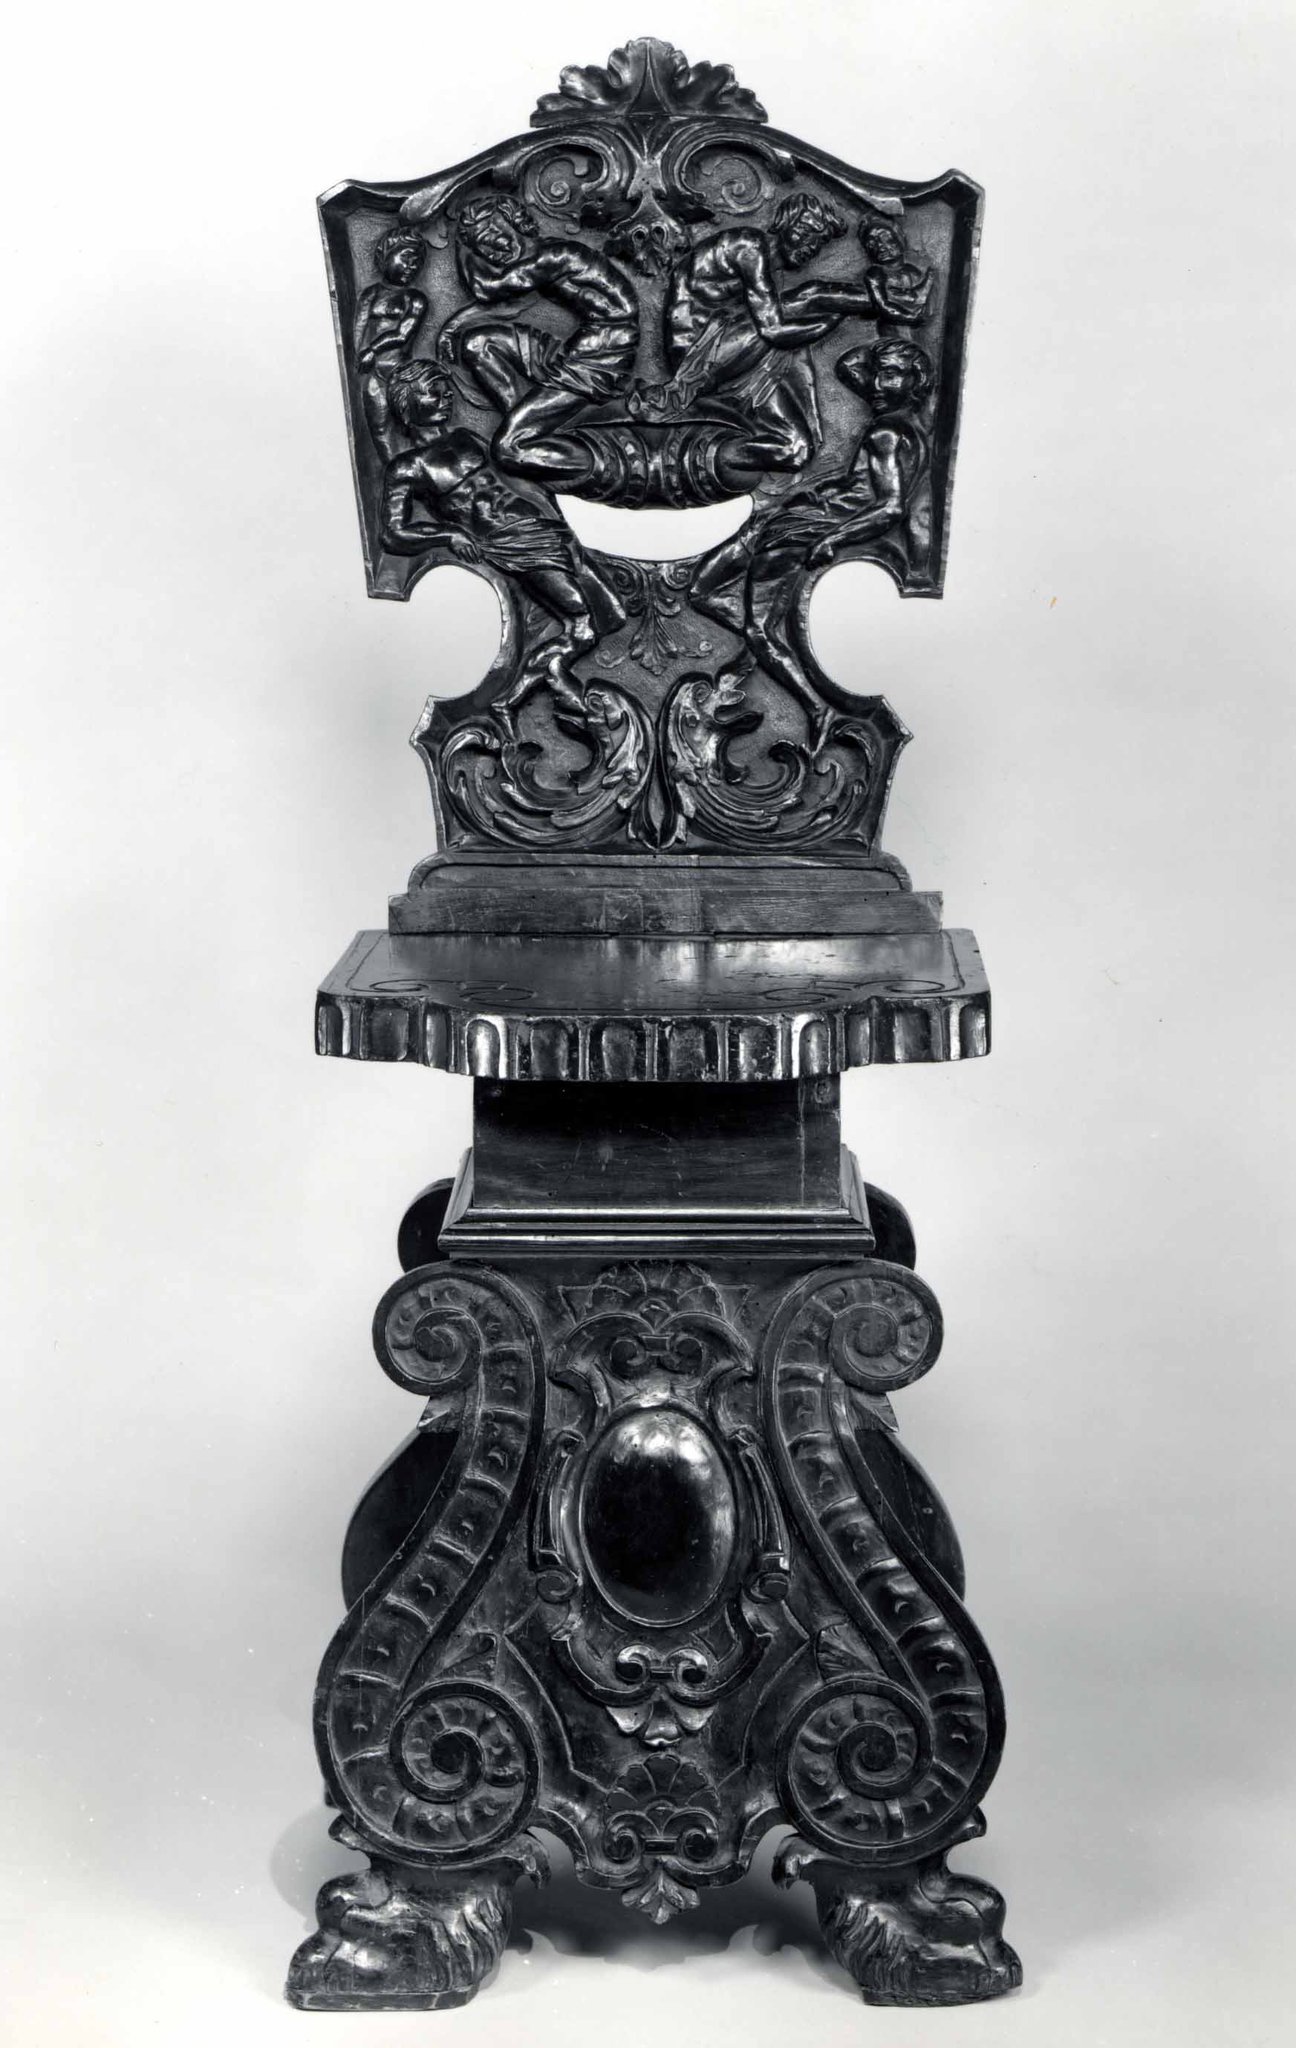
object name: chair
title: Side chair (sgabello, pair with 1975.1.2038)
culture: italian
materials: wood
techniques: carving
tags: men